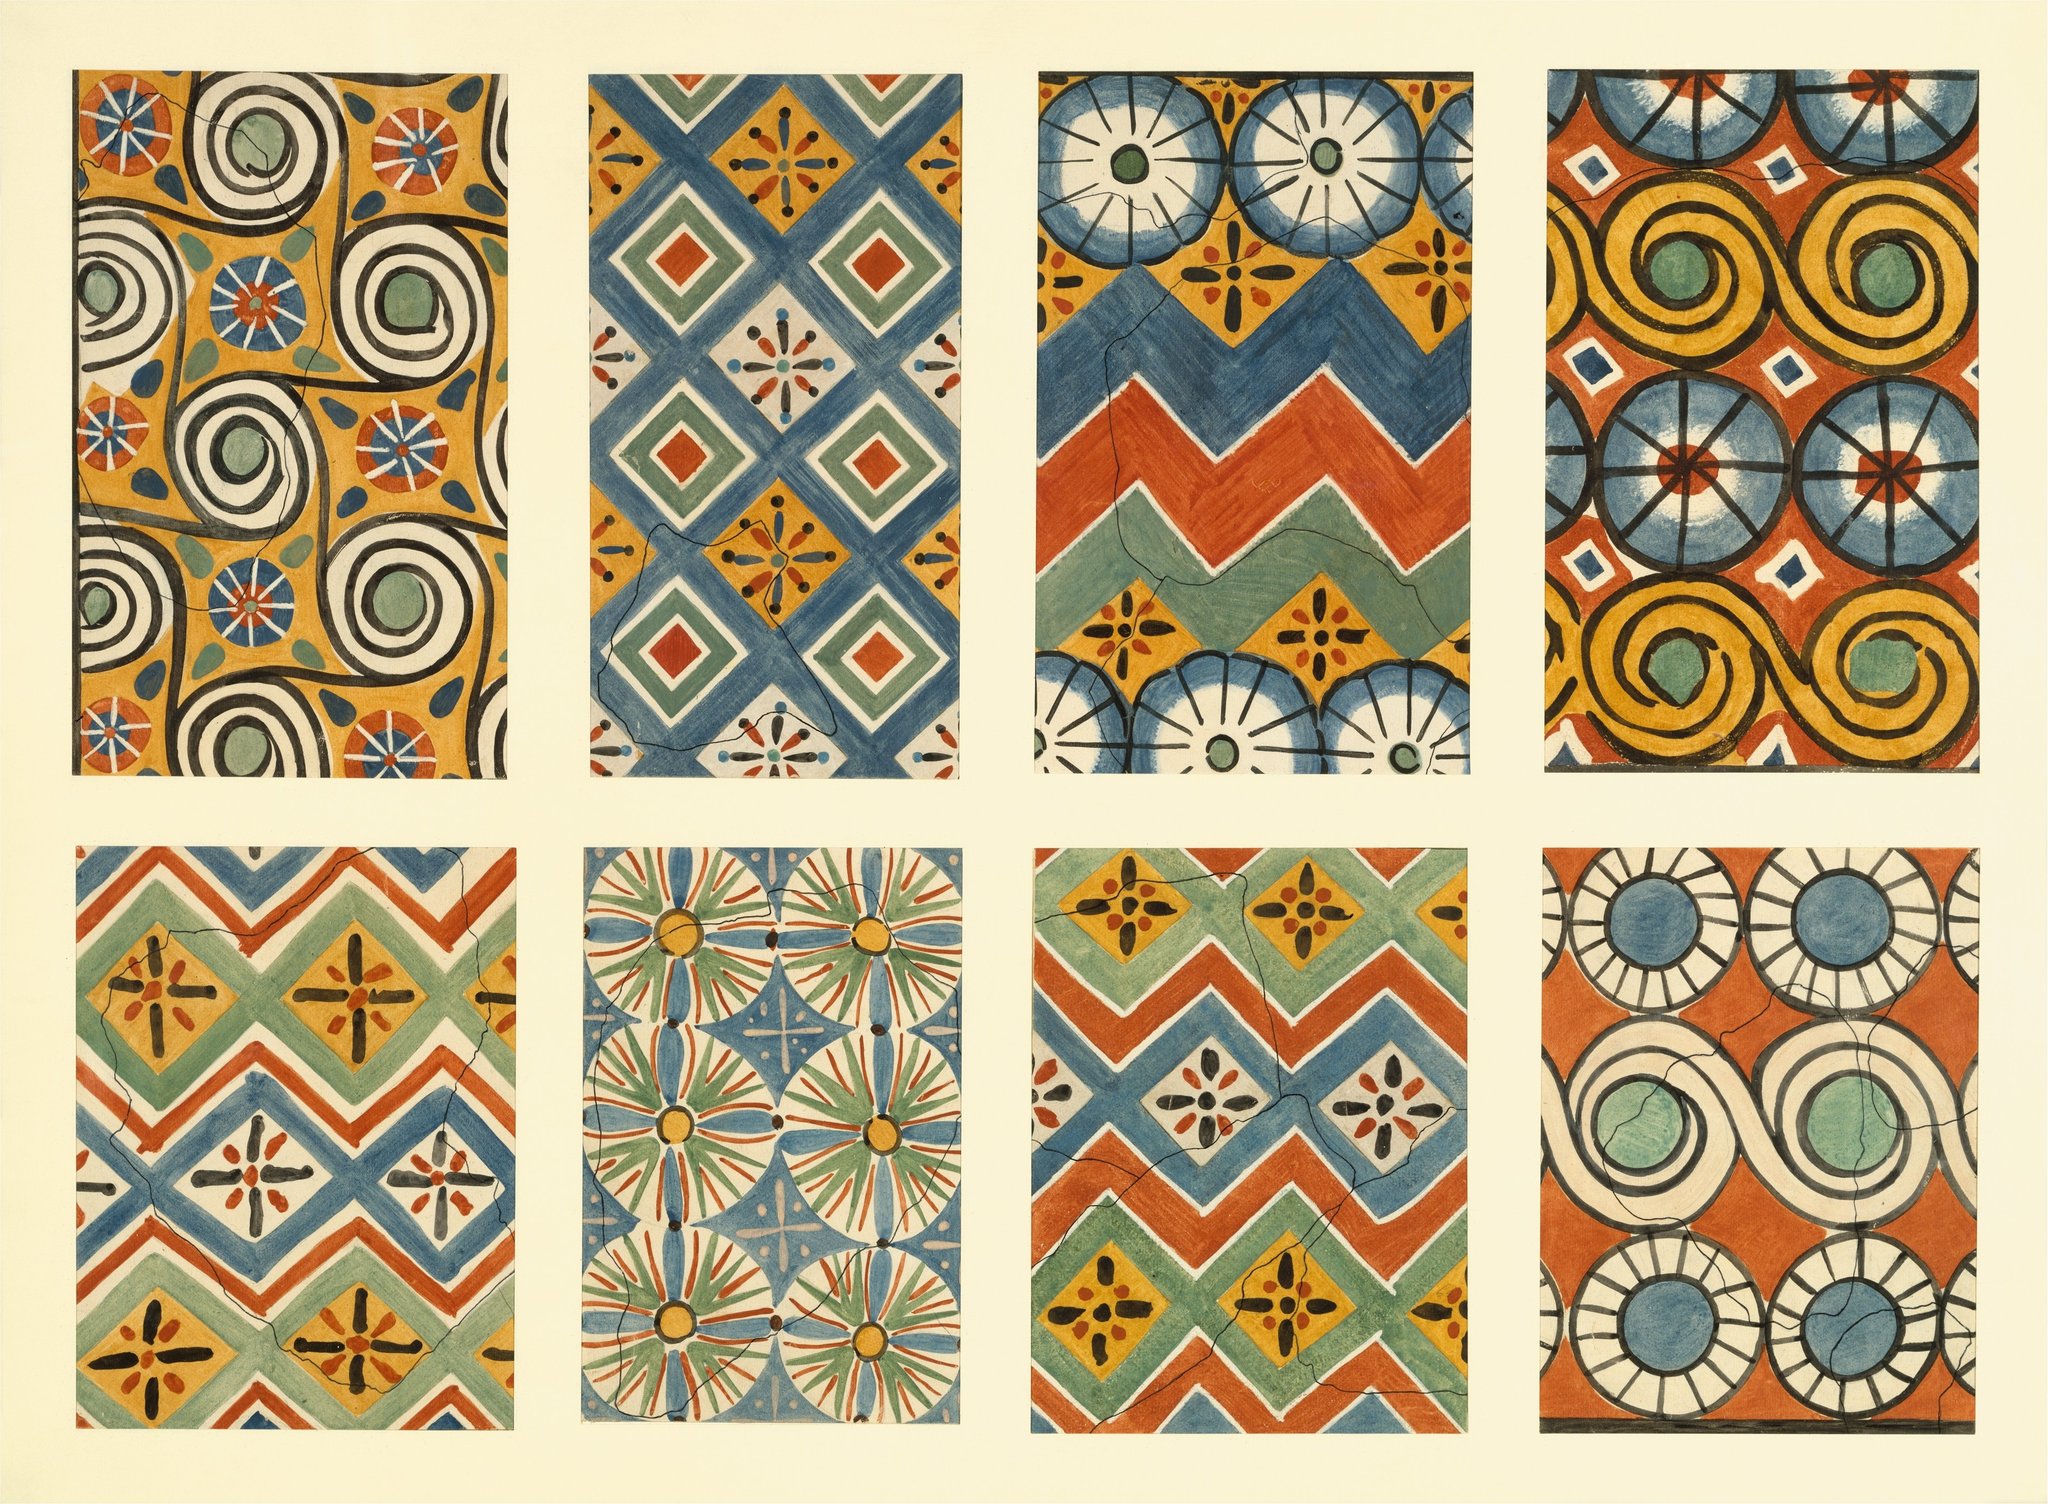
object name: facsimile, nebamun tt 181, ipuky, ceiling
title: Eight Ceiling Patterns, Tomb of Nebamun and Ipuky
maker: nina de garis davies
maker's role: artist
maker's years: 1881-1965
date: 1390-1349 BCE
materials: paper, paint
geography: egypt